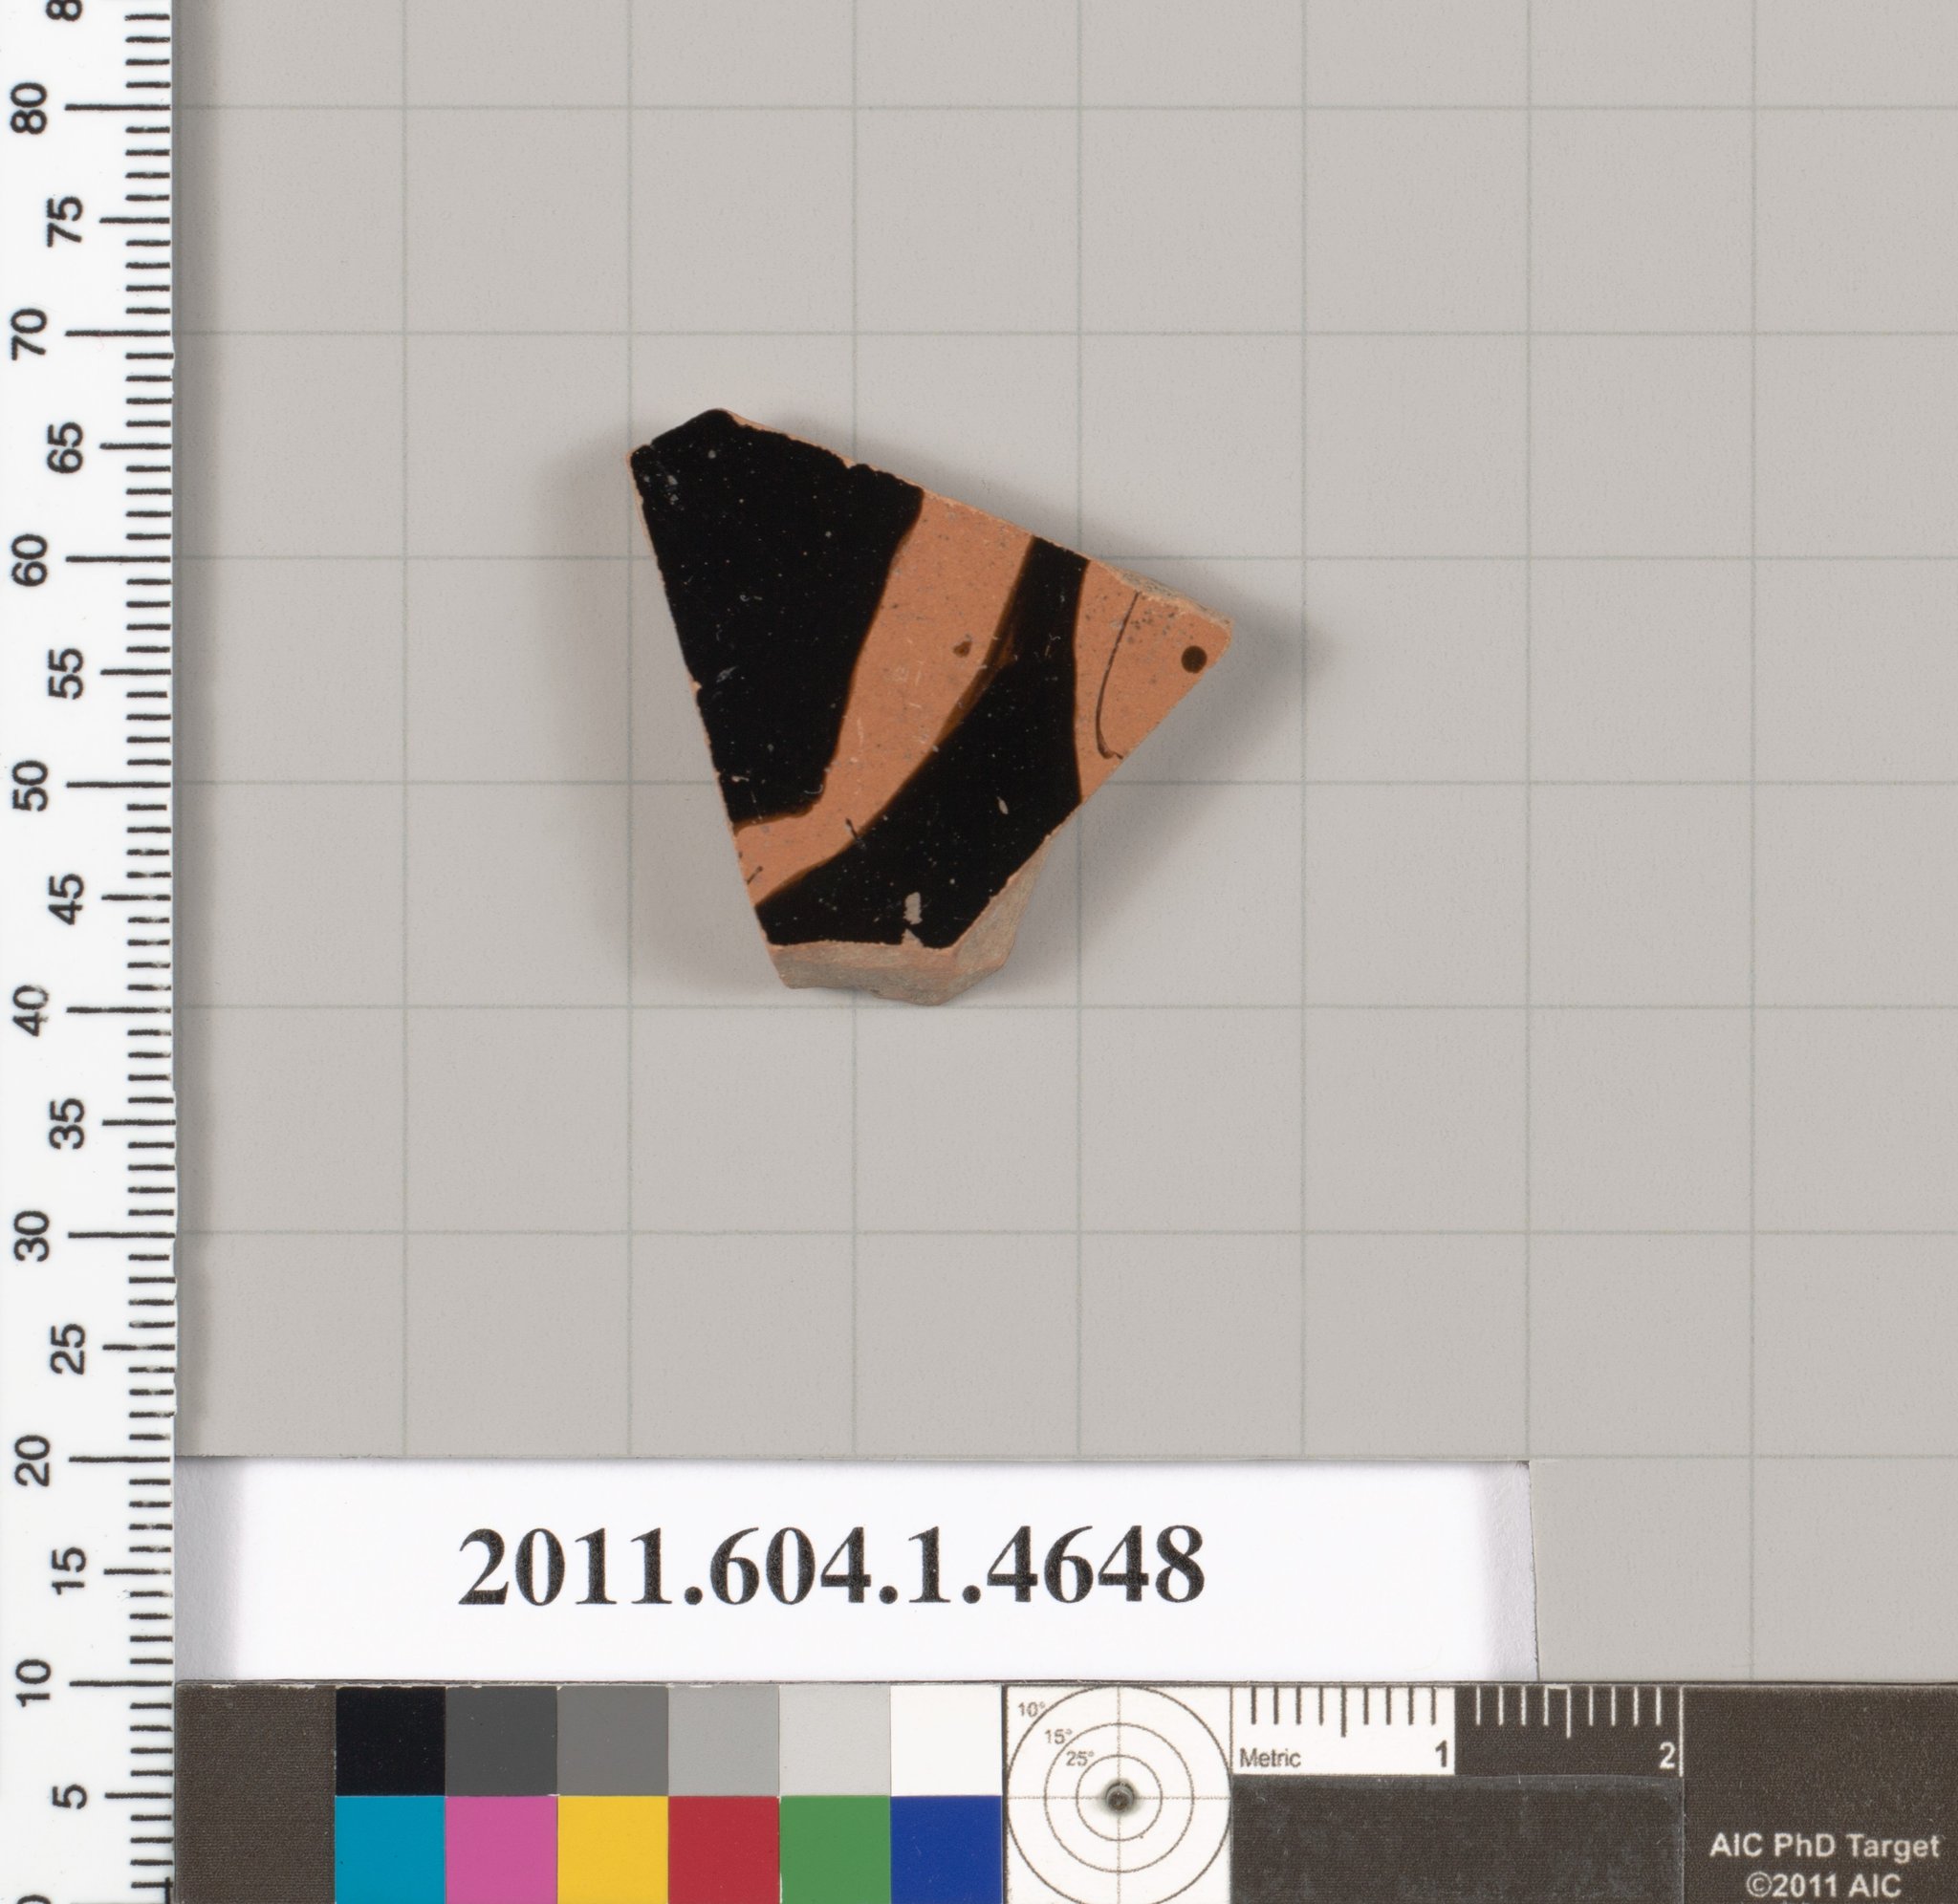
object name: kylix fragment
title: Terracotta fragment of a kylix (drinking cup)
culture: greek, attic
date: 480-470 BCE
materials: terracotta